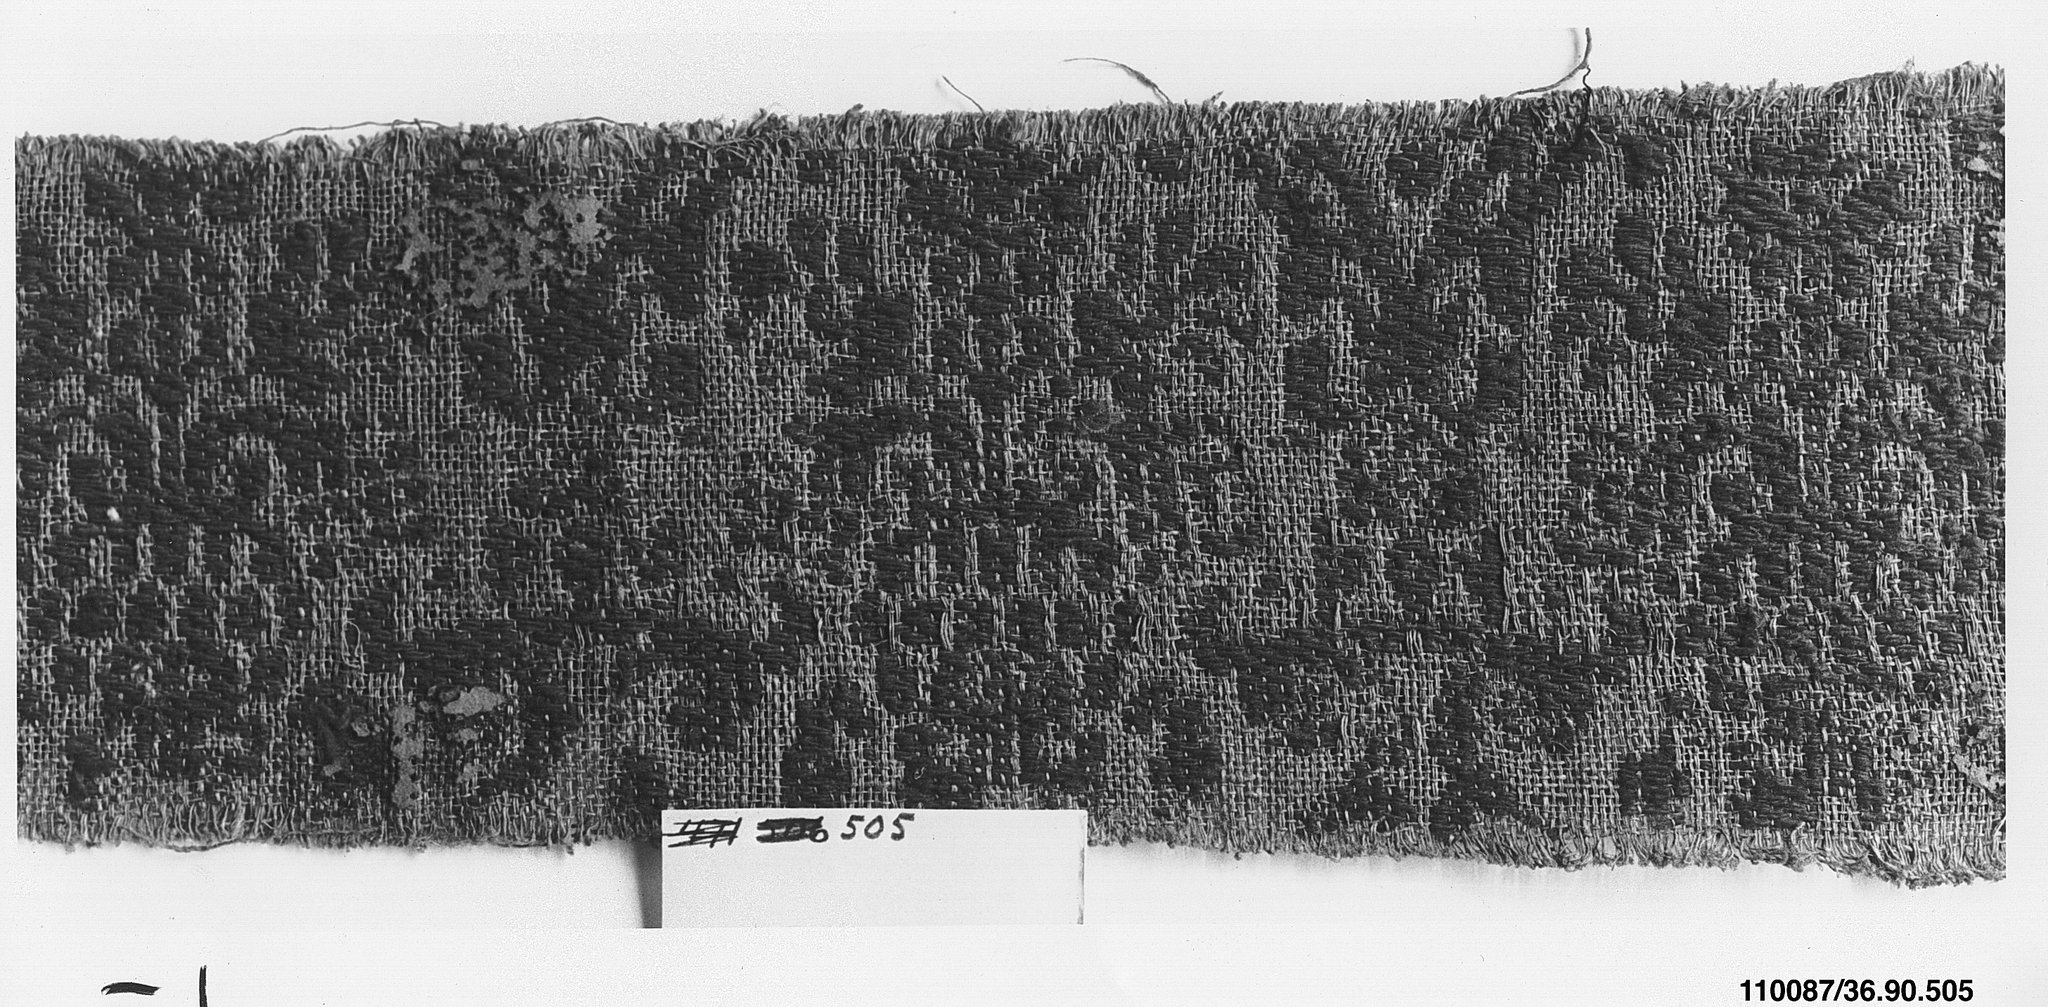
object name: piece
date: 1501-1700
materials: hemp, wool